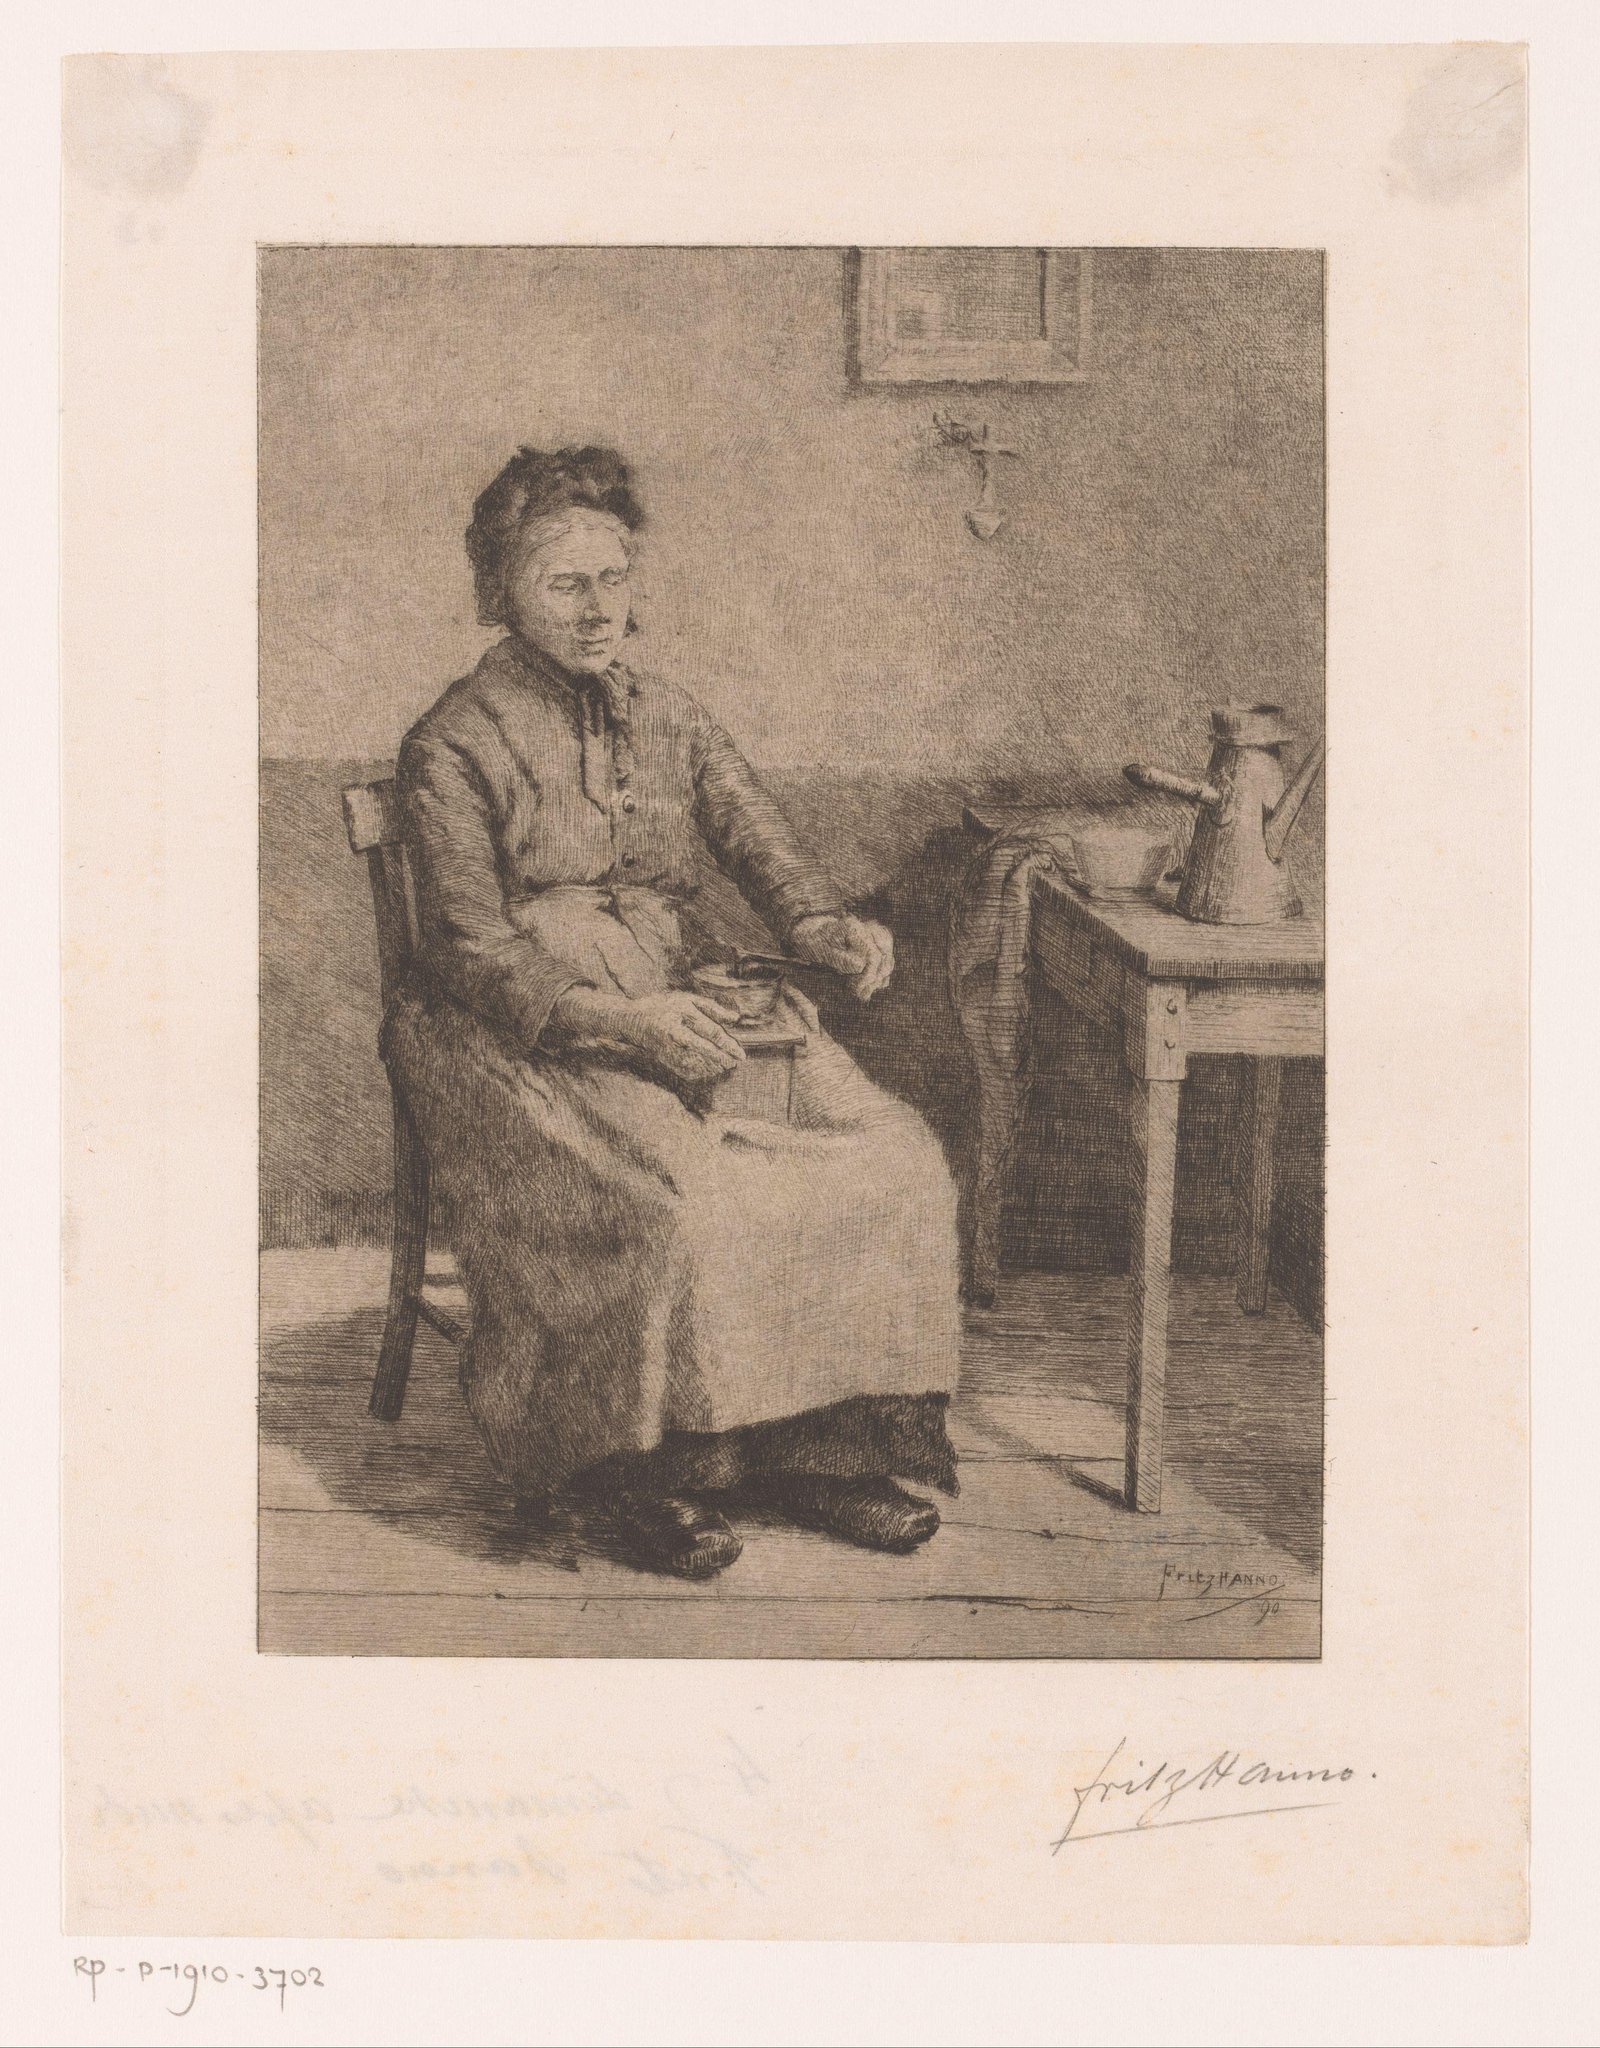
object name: print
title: Vrouw met een koffiemolen in de keuken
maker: fritz hanno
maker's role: print maker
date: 1890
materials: paper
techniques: etching, intaglio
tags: kitchen, coffee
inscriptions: workshop stamp: ‘Antwerpsche Etsers 1880’, annotation: ‘4 dimanche apres mini Frits Hanno’, collector's mark: Lugt 2228